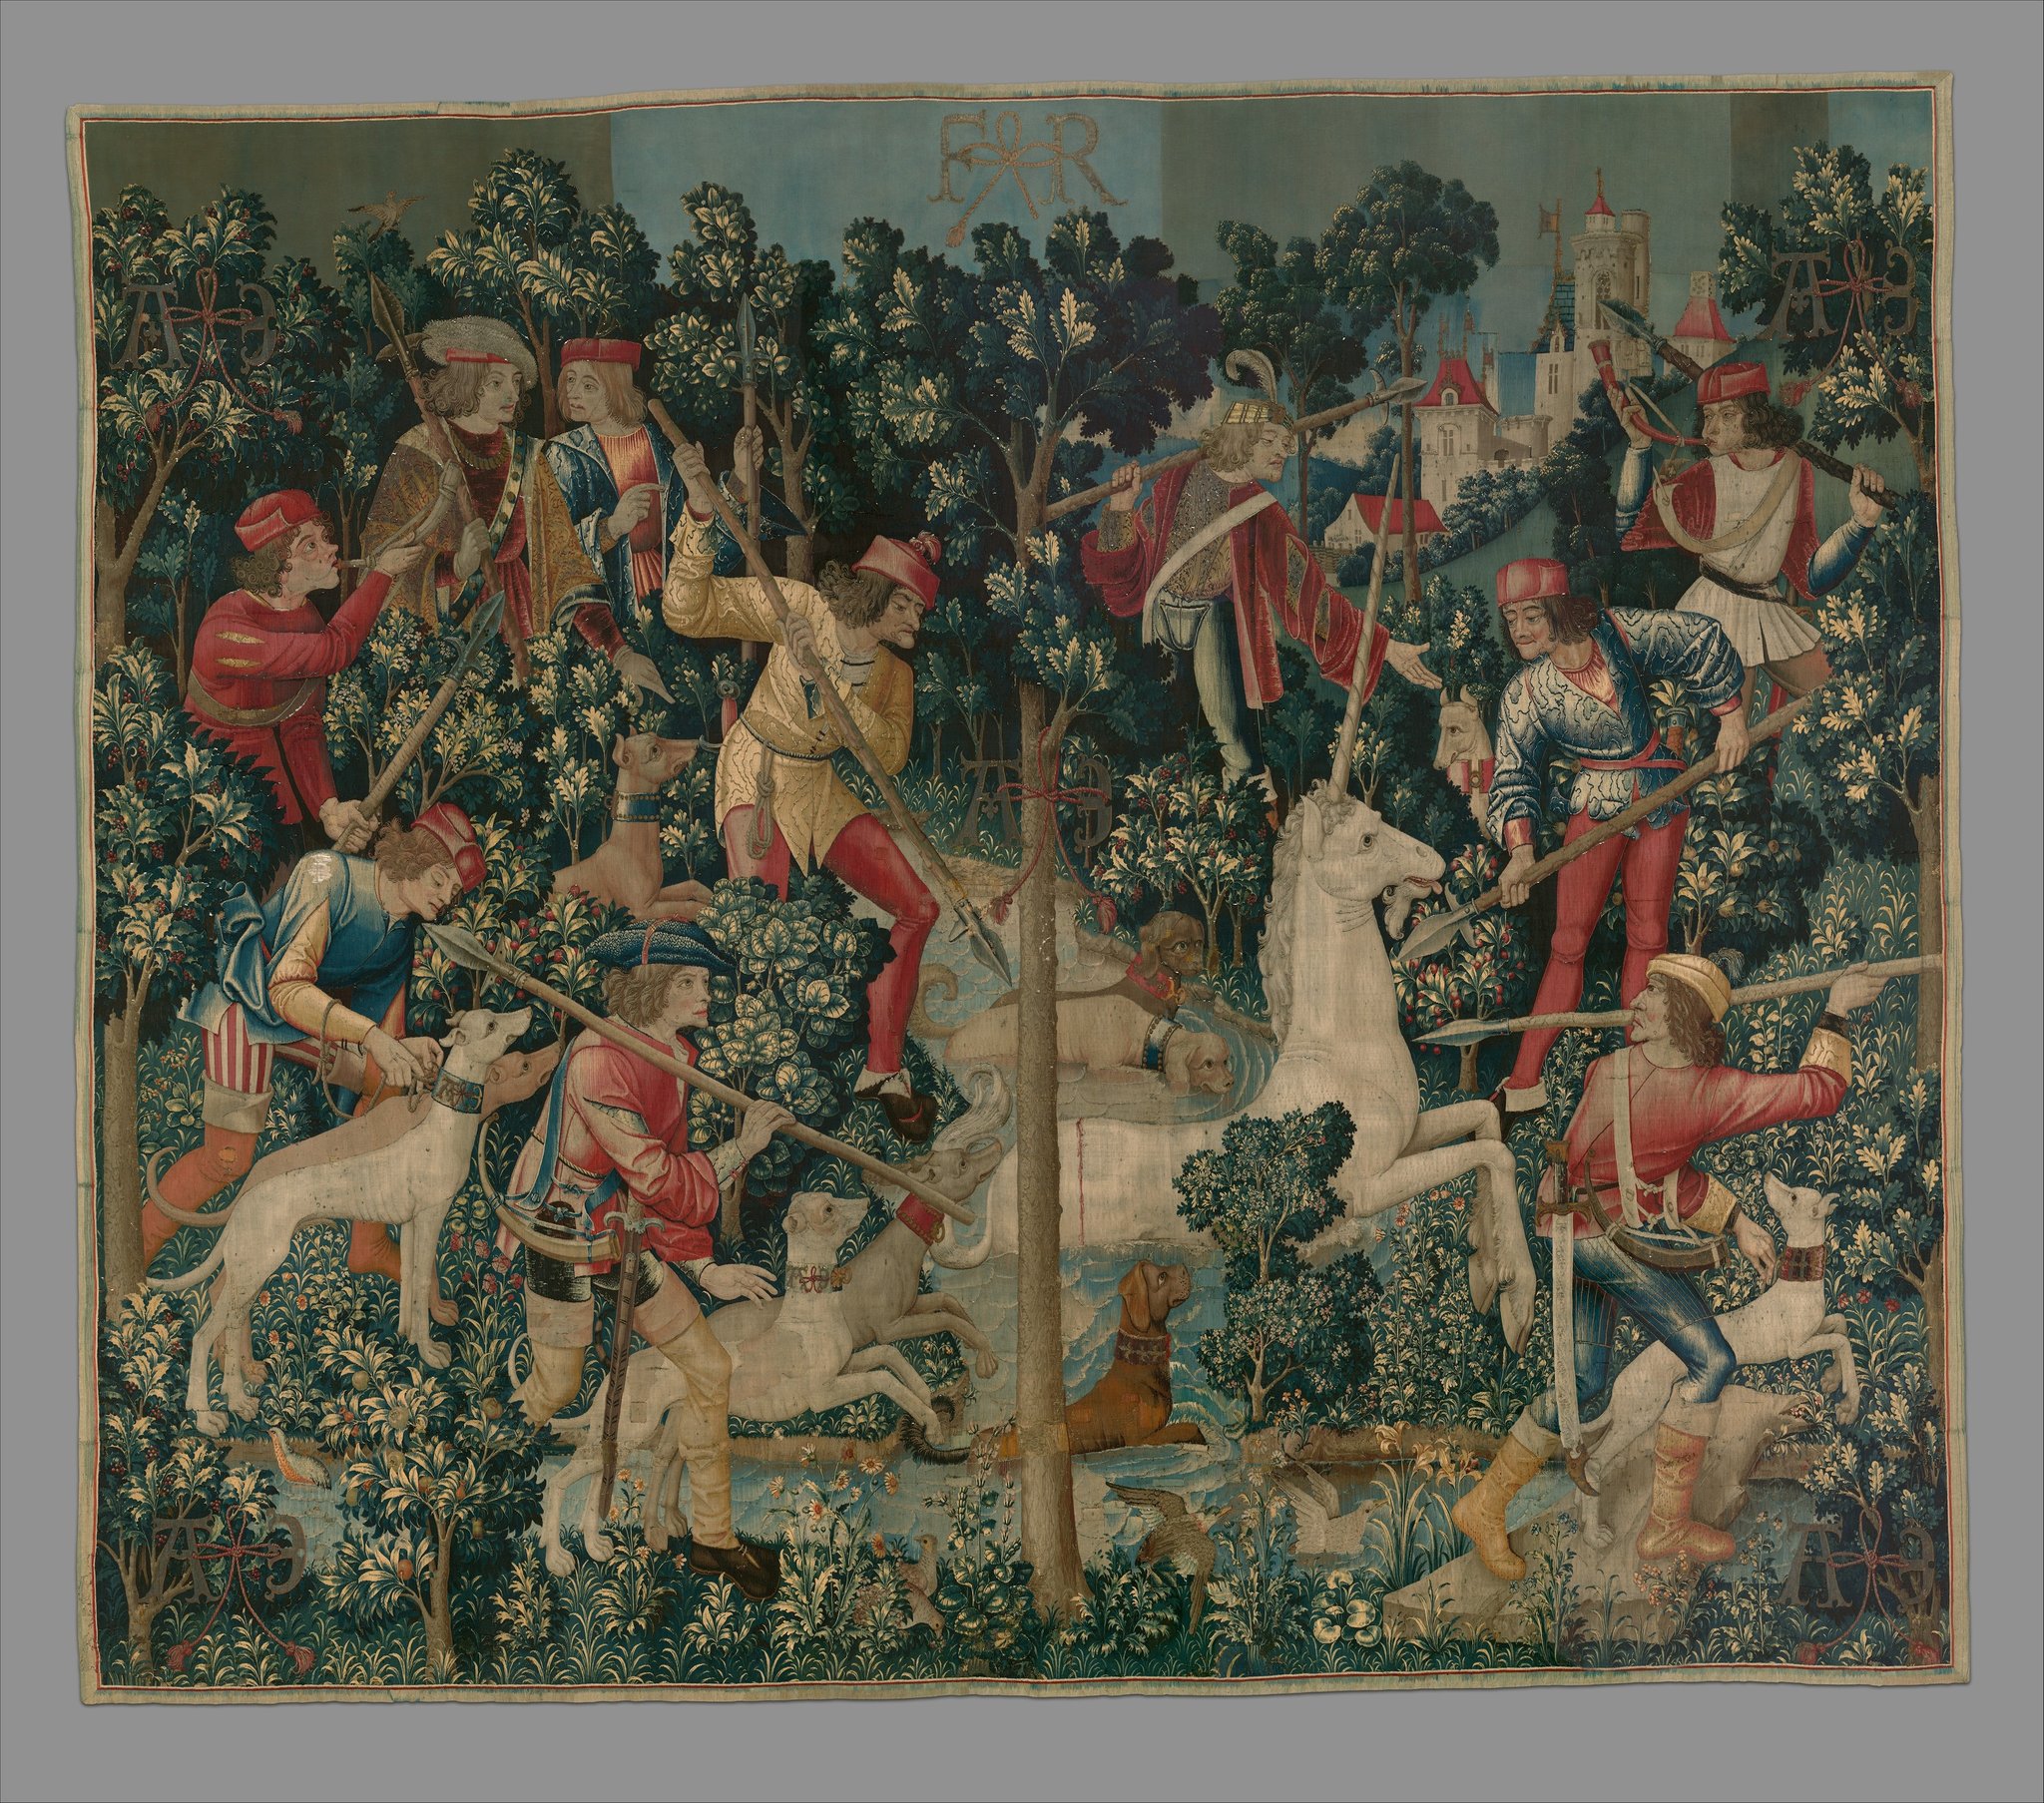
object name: tapestry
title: The Unicorn Crosses a Stream (from the Unicorn Tapestries)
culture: french or south netherlandish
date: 1495-1505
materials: gilt, silk, silver, wool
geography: netherlands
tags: birds,castles,spears,men,hunting,horns,unicorns,dogs,forests,trees